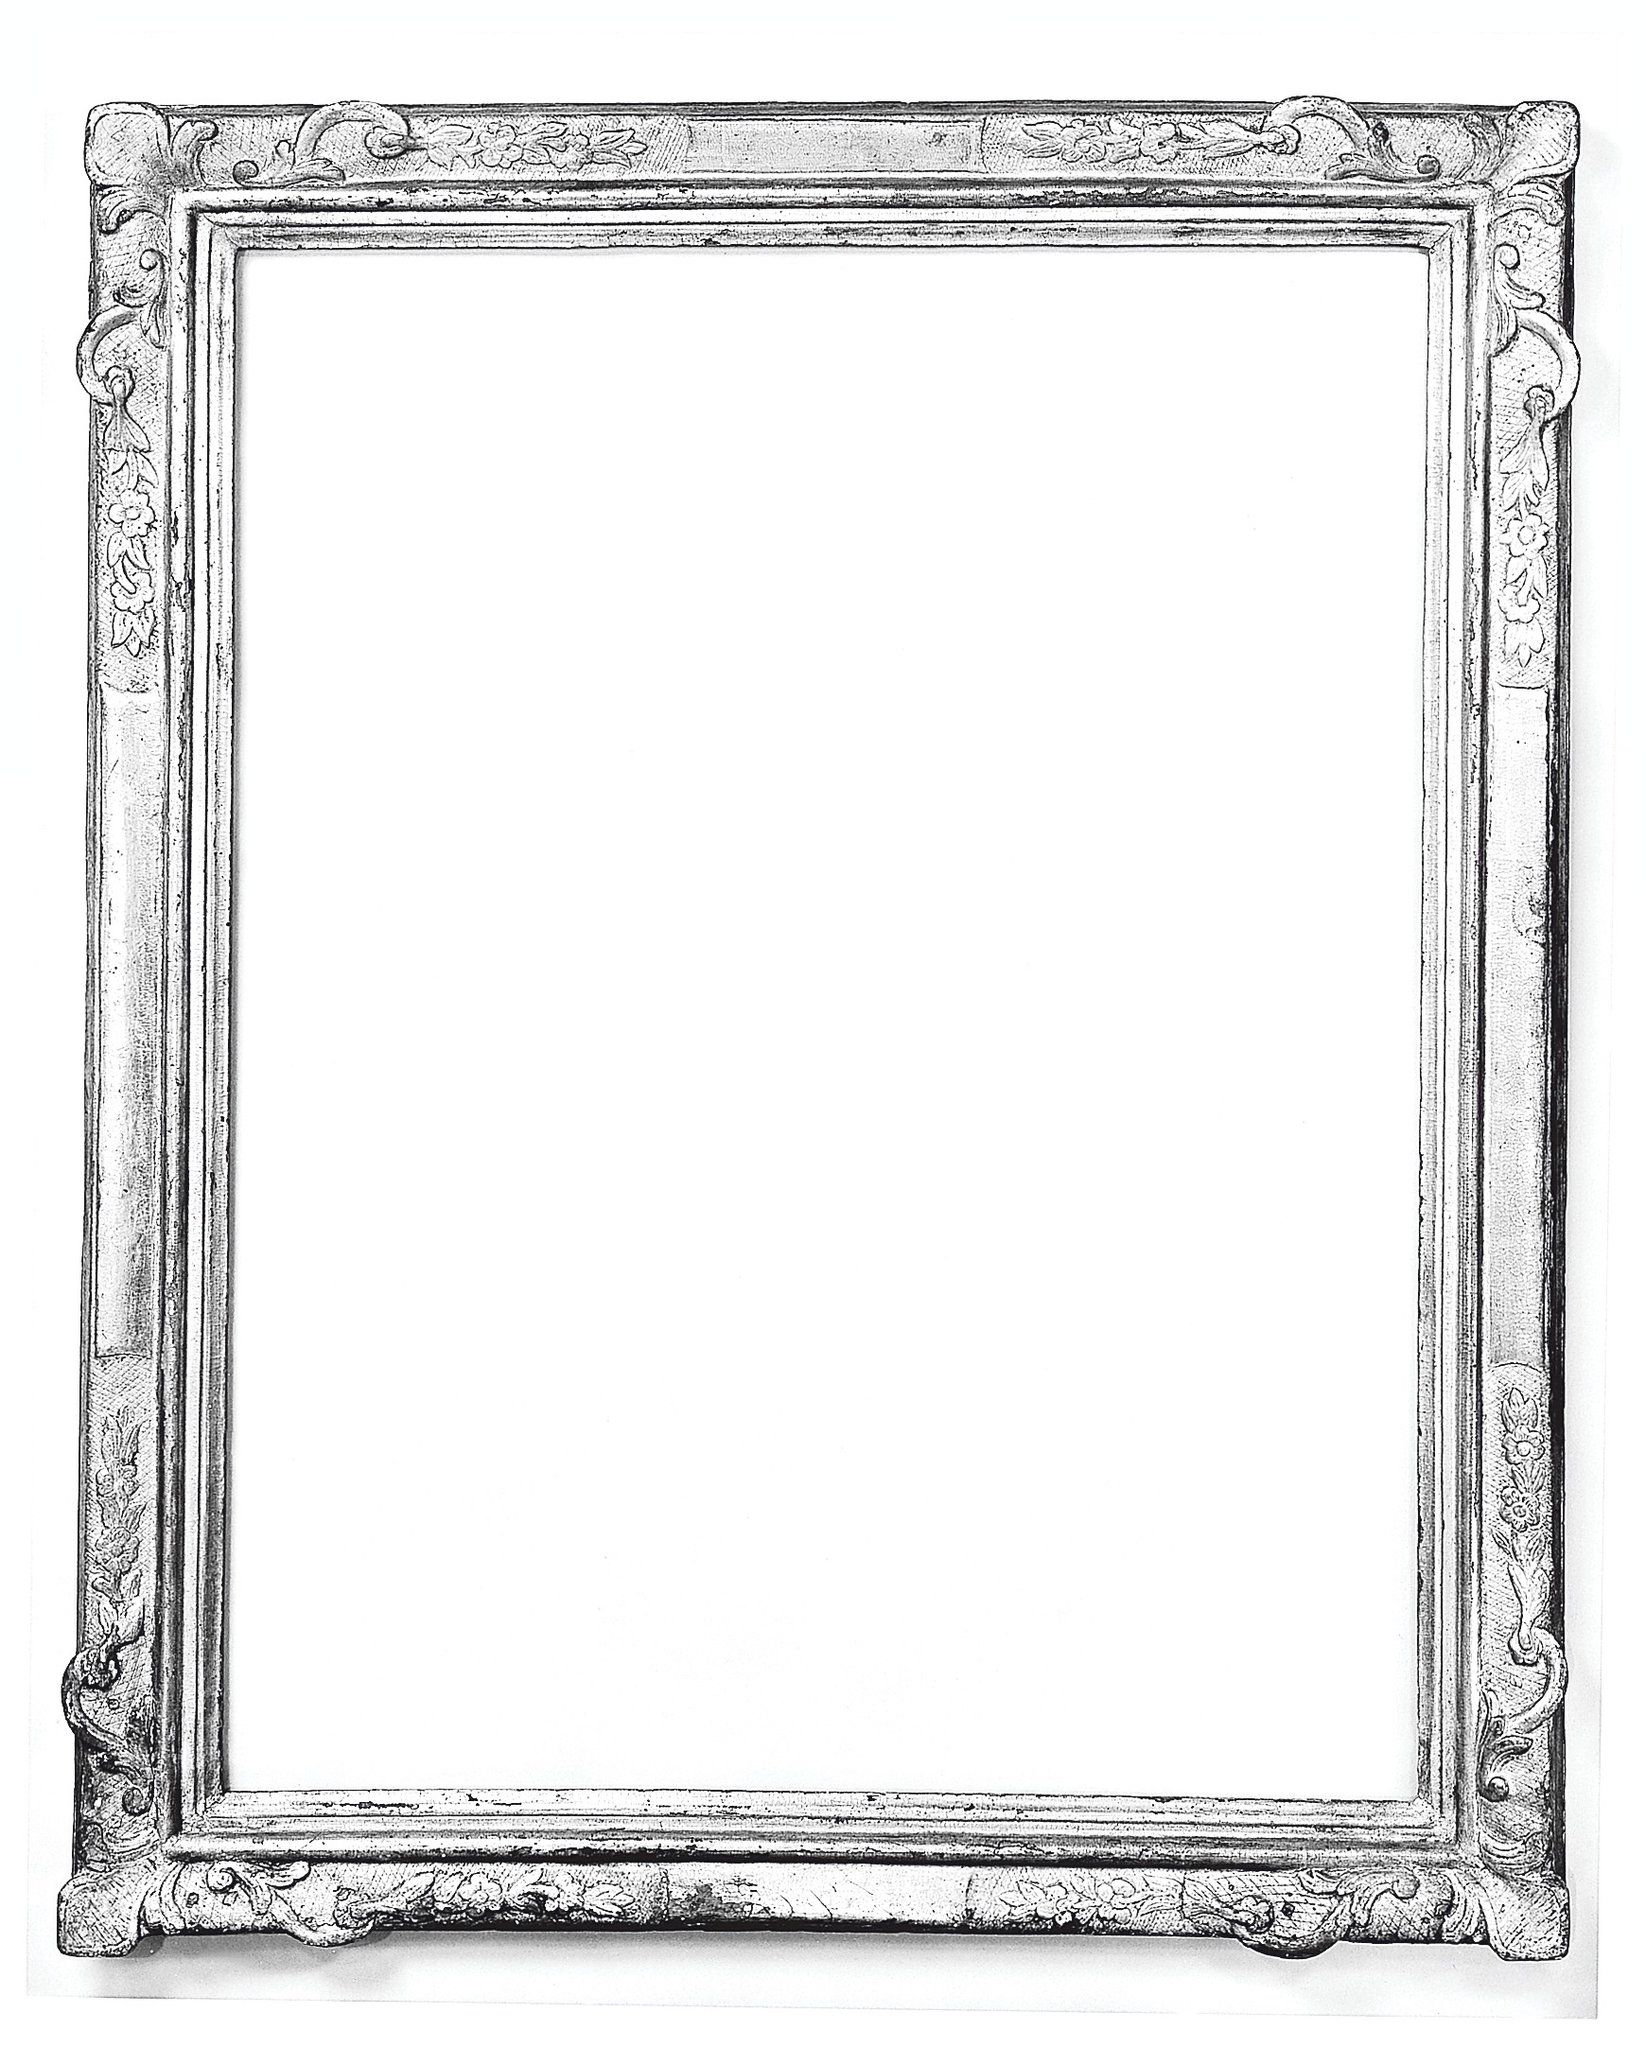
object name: frame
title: Corner-flower frame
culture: french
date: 1690-1700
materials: feather, wood